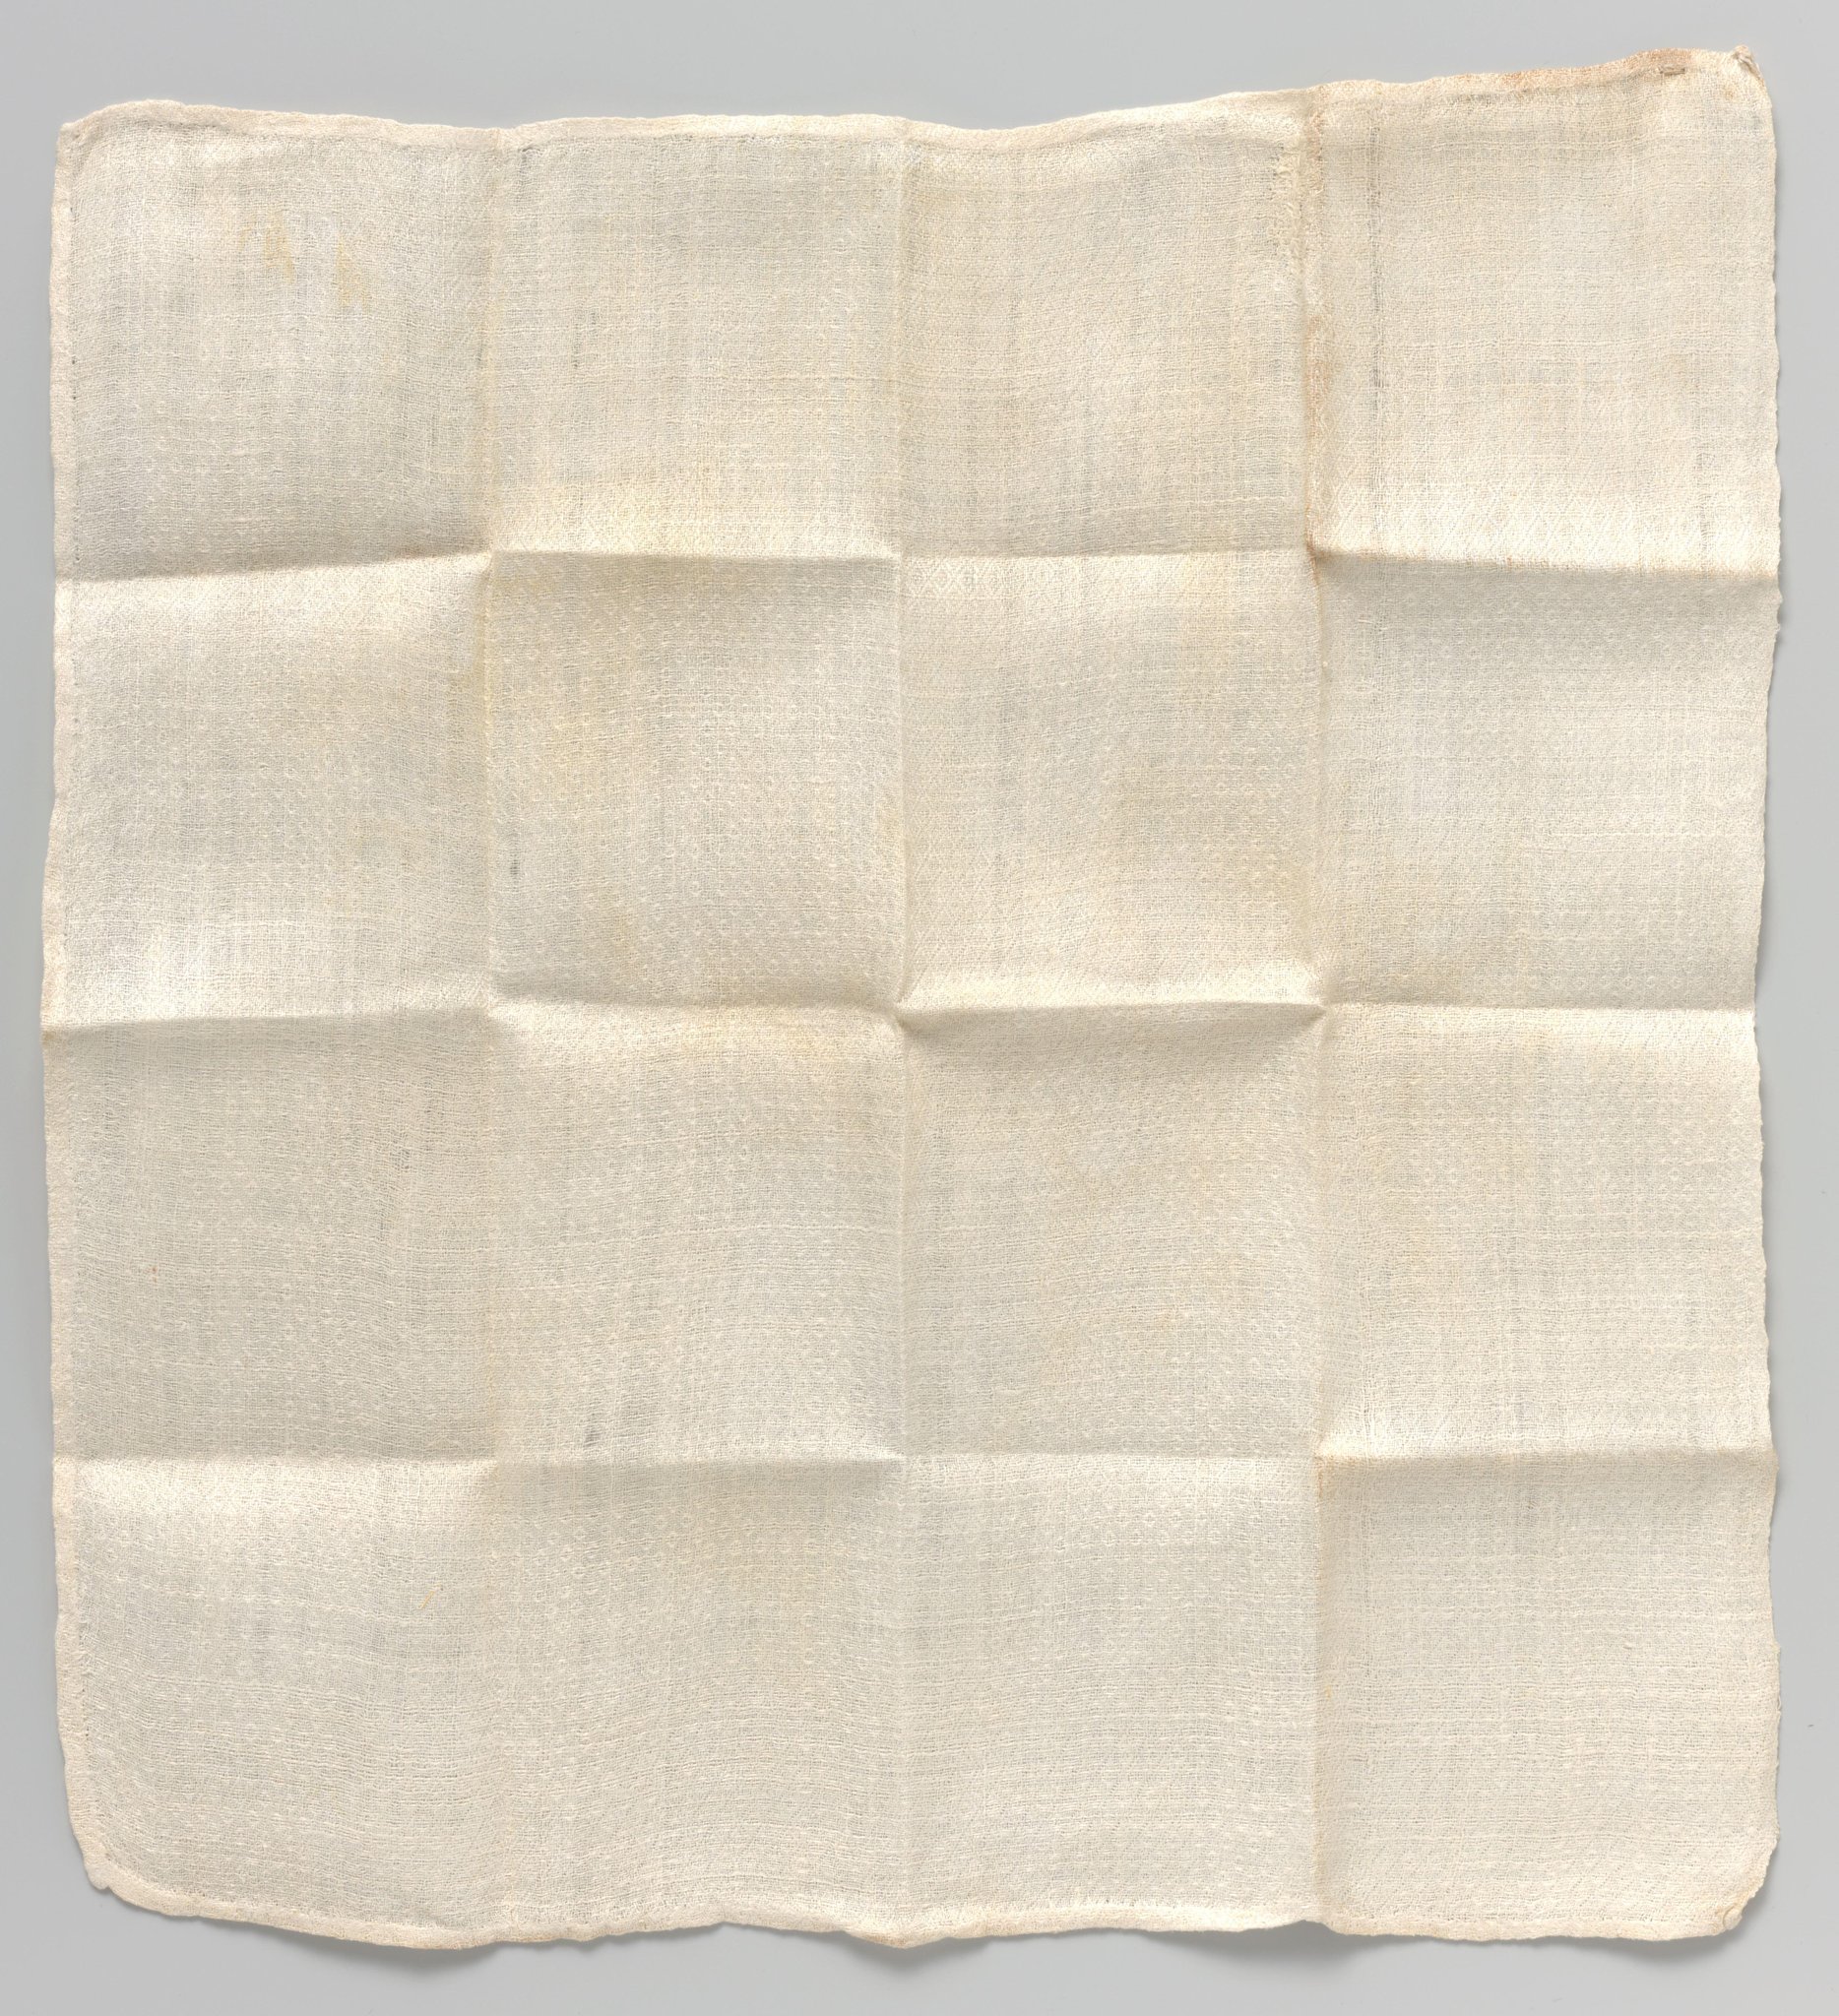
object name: napkin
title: Wit servet met ingeweven ruitjespatroon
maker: Anonymous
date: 1800-1930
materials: textile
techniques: weave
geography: europe